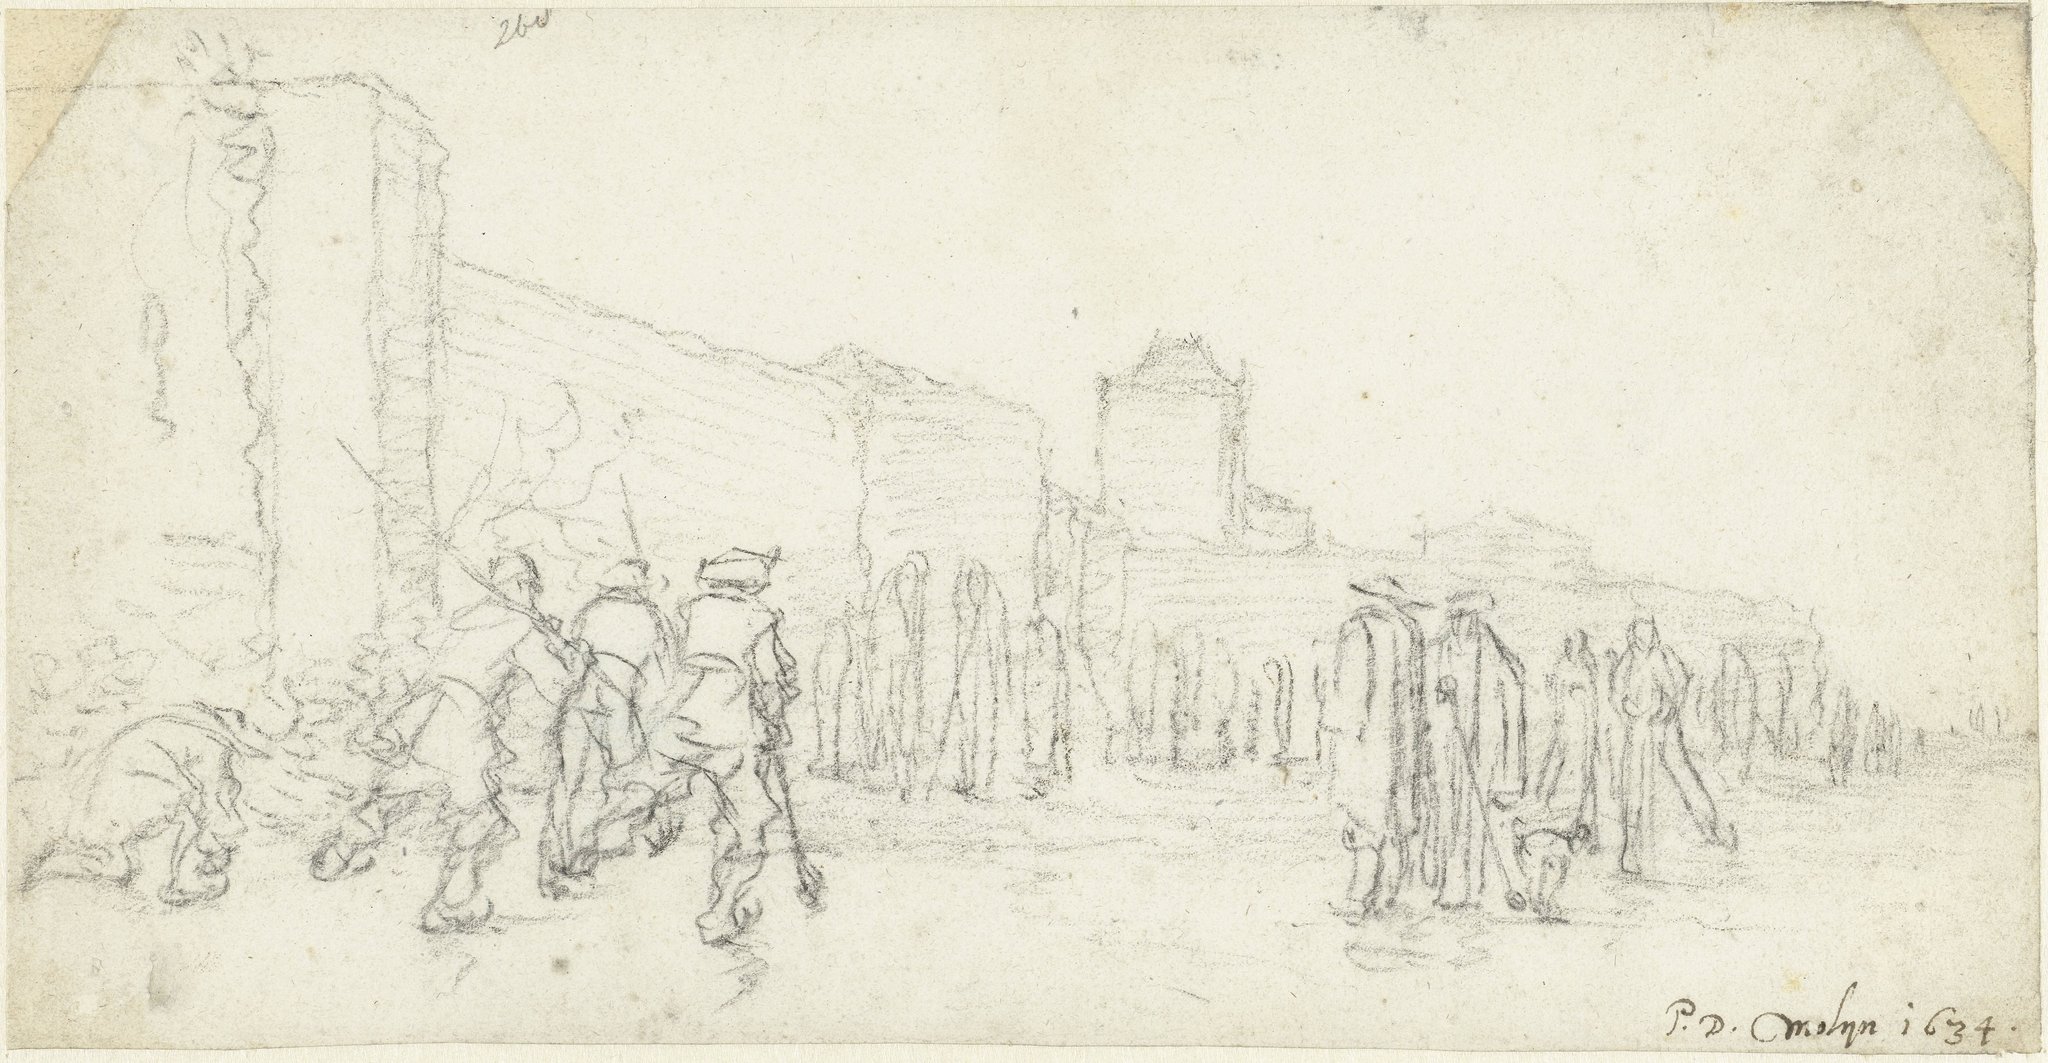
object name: drawing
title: IJsvermaak bij de Zijlpoort te Haarlem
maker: gerard ter borch (ii)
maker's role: draughtsman, painter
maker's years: 1617-1681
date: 1634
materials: chalk, paper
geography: haarlem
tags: winter sports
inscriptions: date and inscription: ‘P.D. Molyn 1634’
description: Aanvankelijk toegeschreven aan Pieter Molijn, vanwege de annotatie, maar waarschijnlijk door Gerard (II) gemaakt onder leiding van zijn leermeester Molijn in diens atelier.